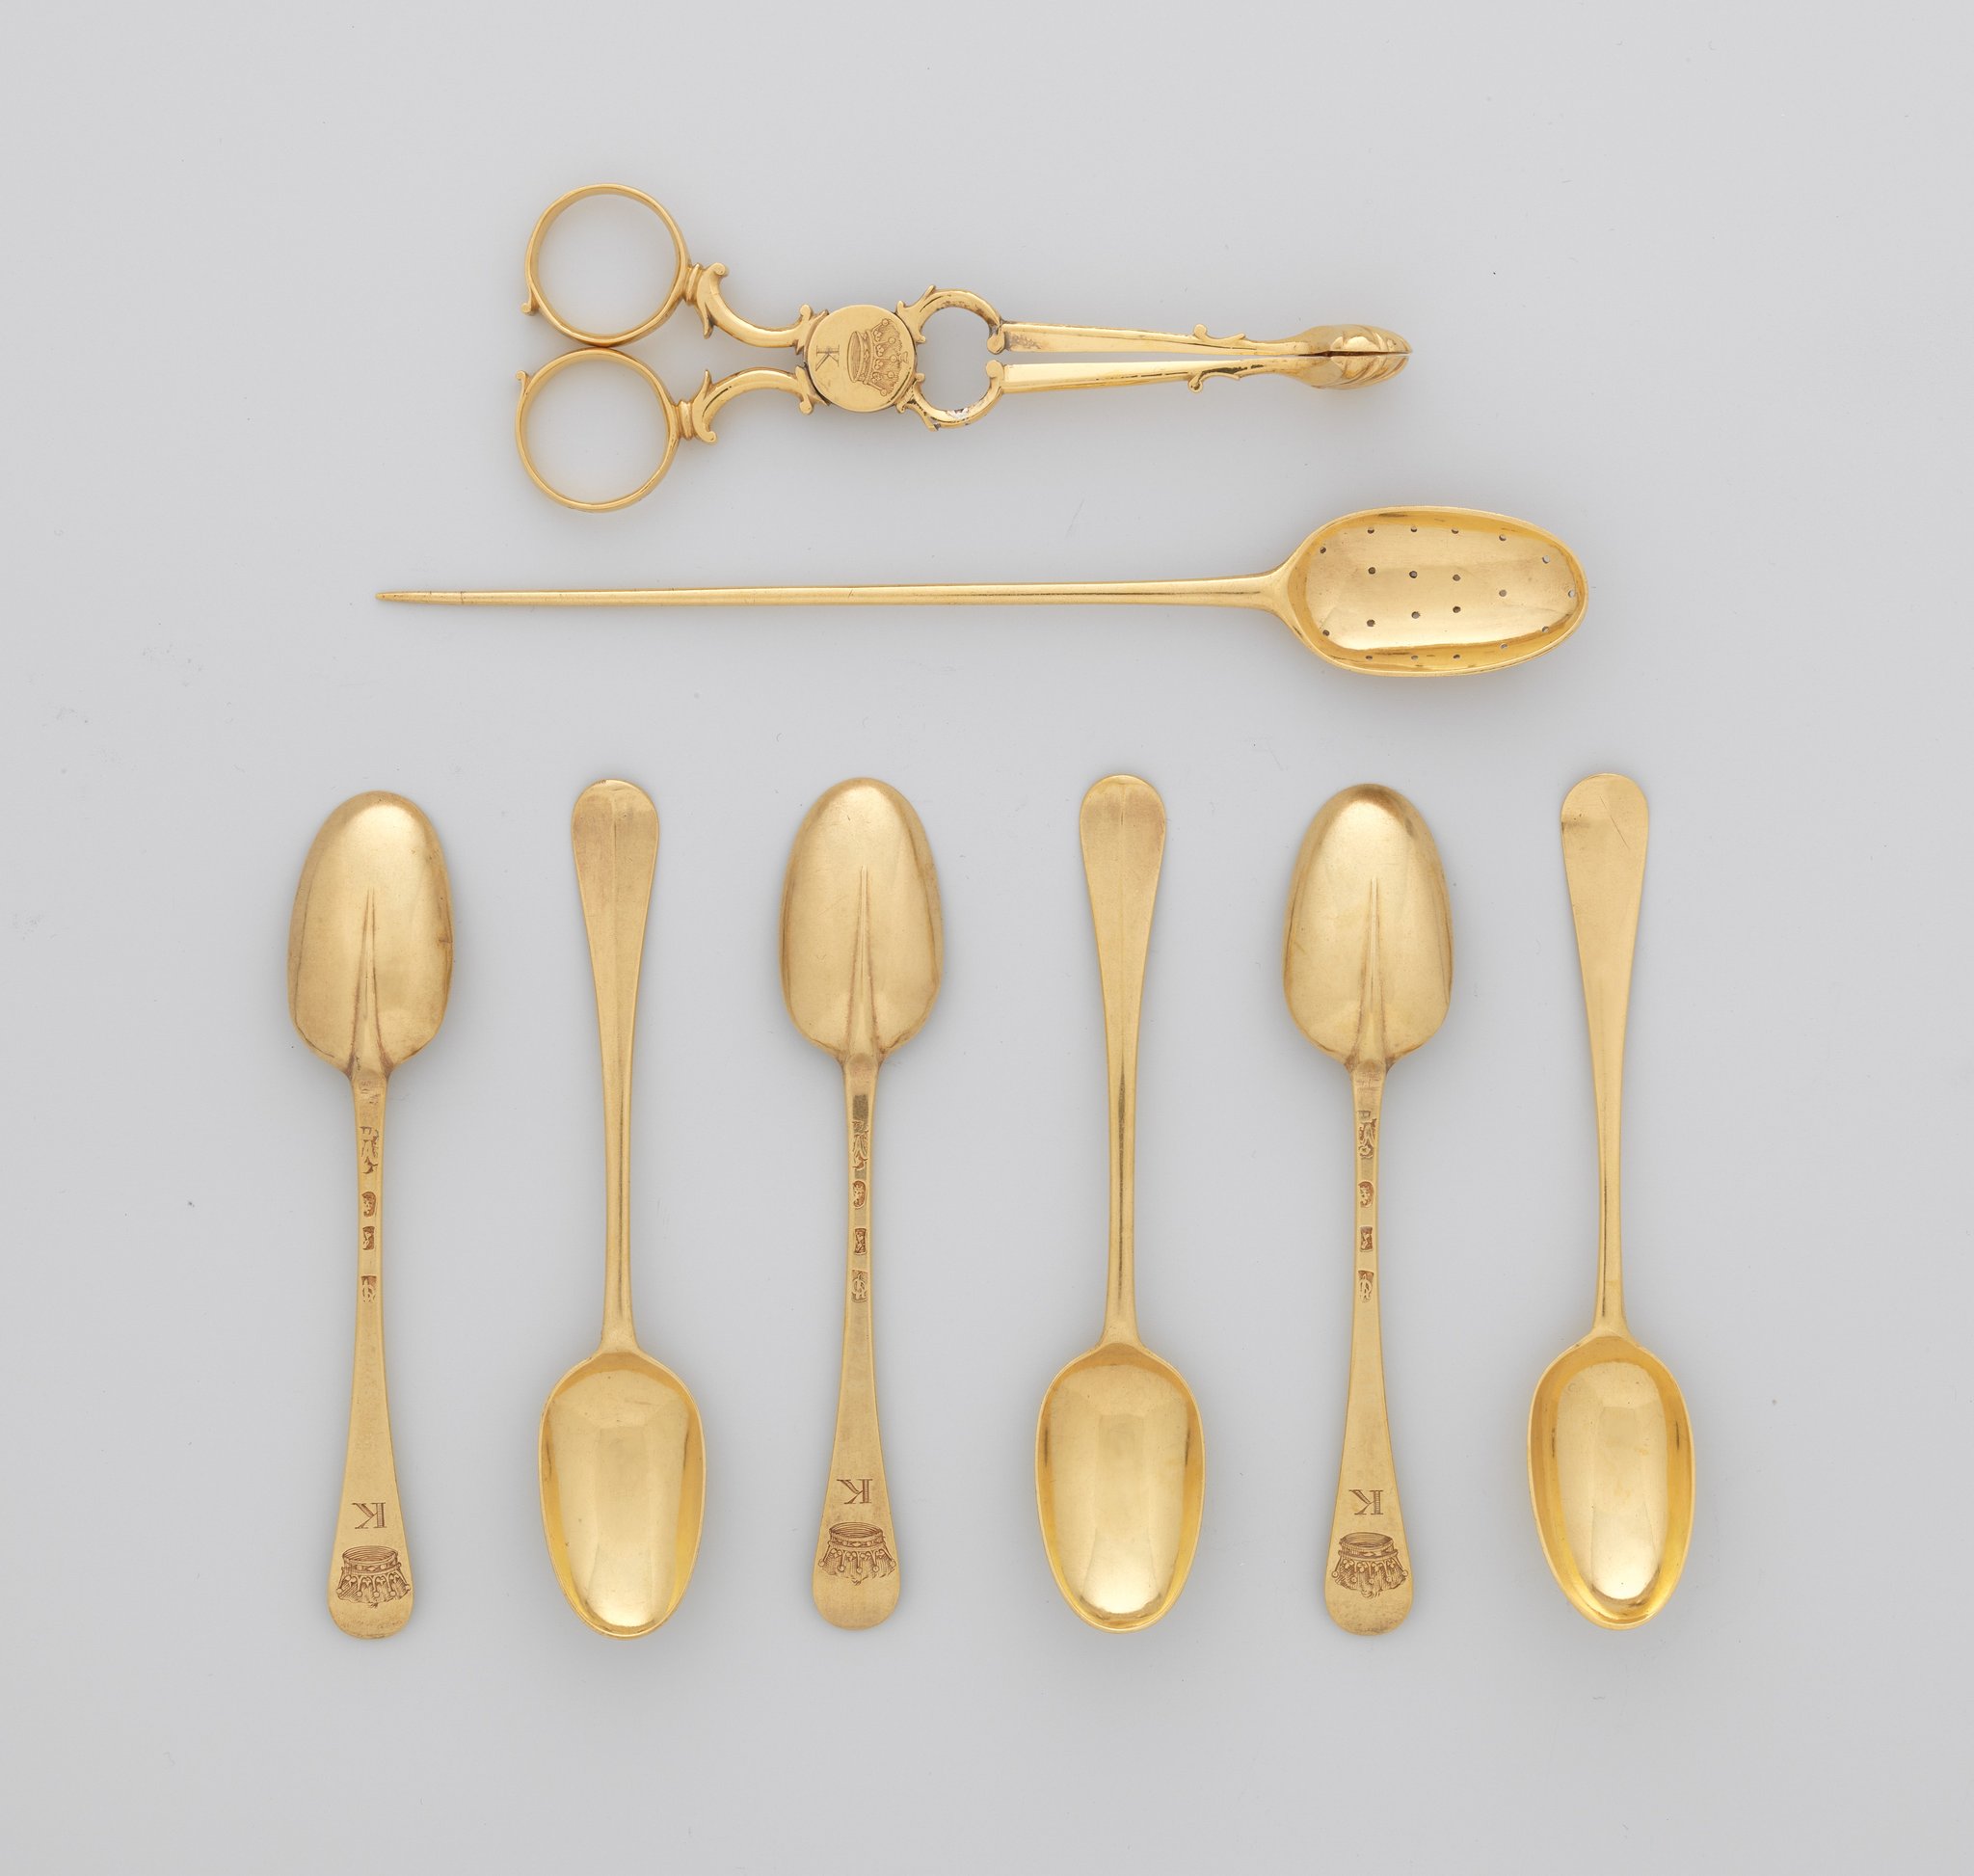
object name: teaspoon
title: Teaspoon (part of a set)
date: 1749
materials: gold